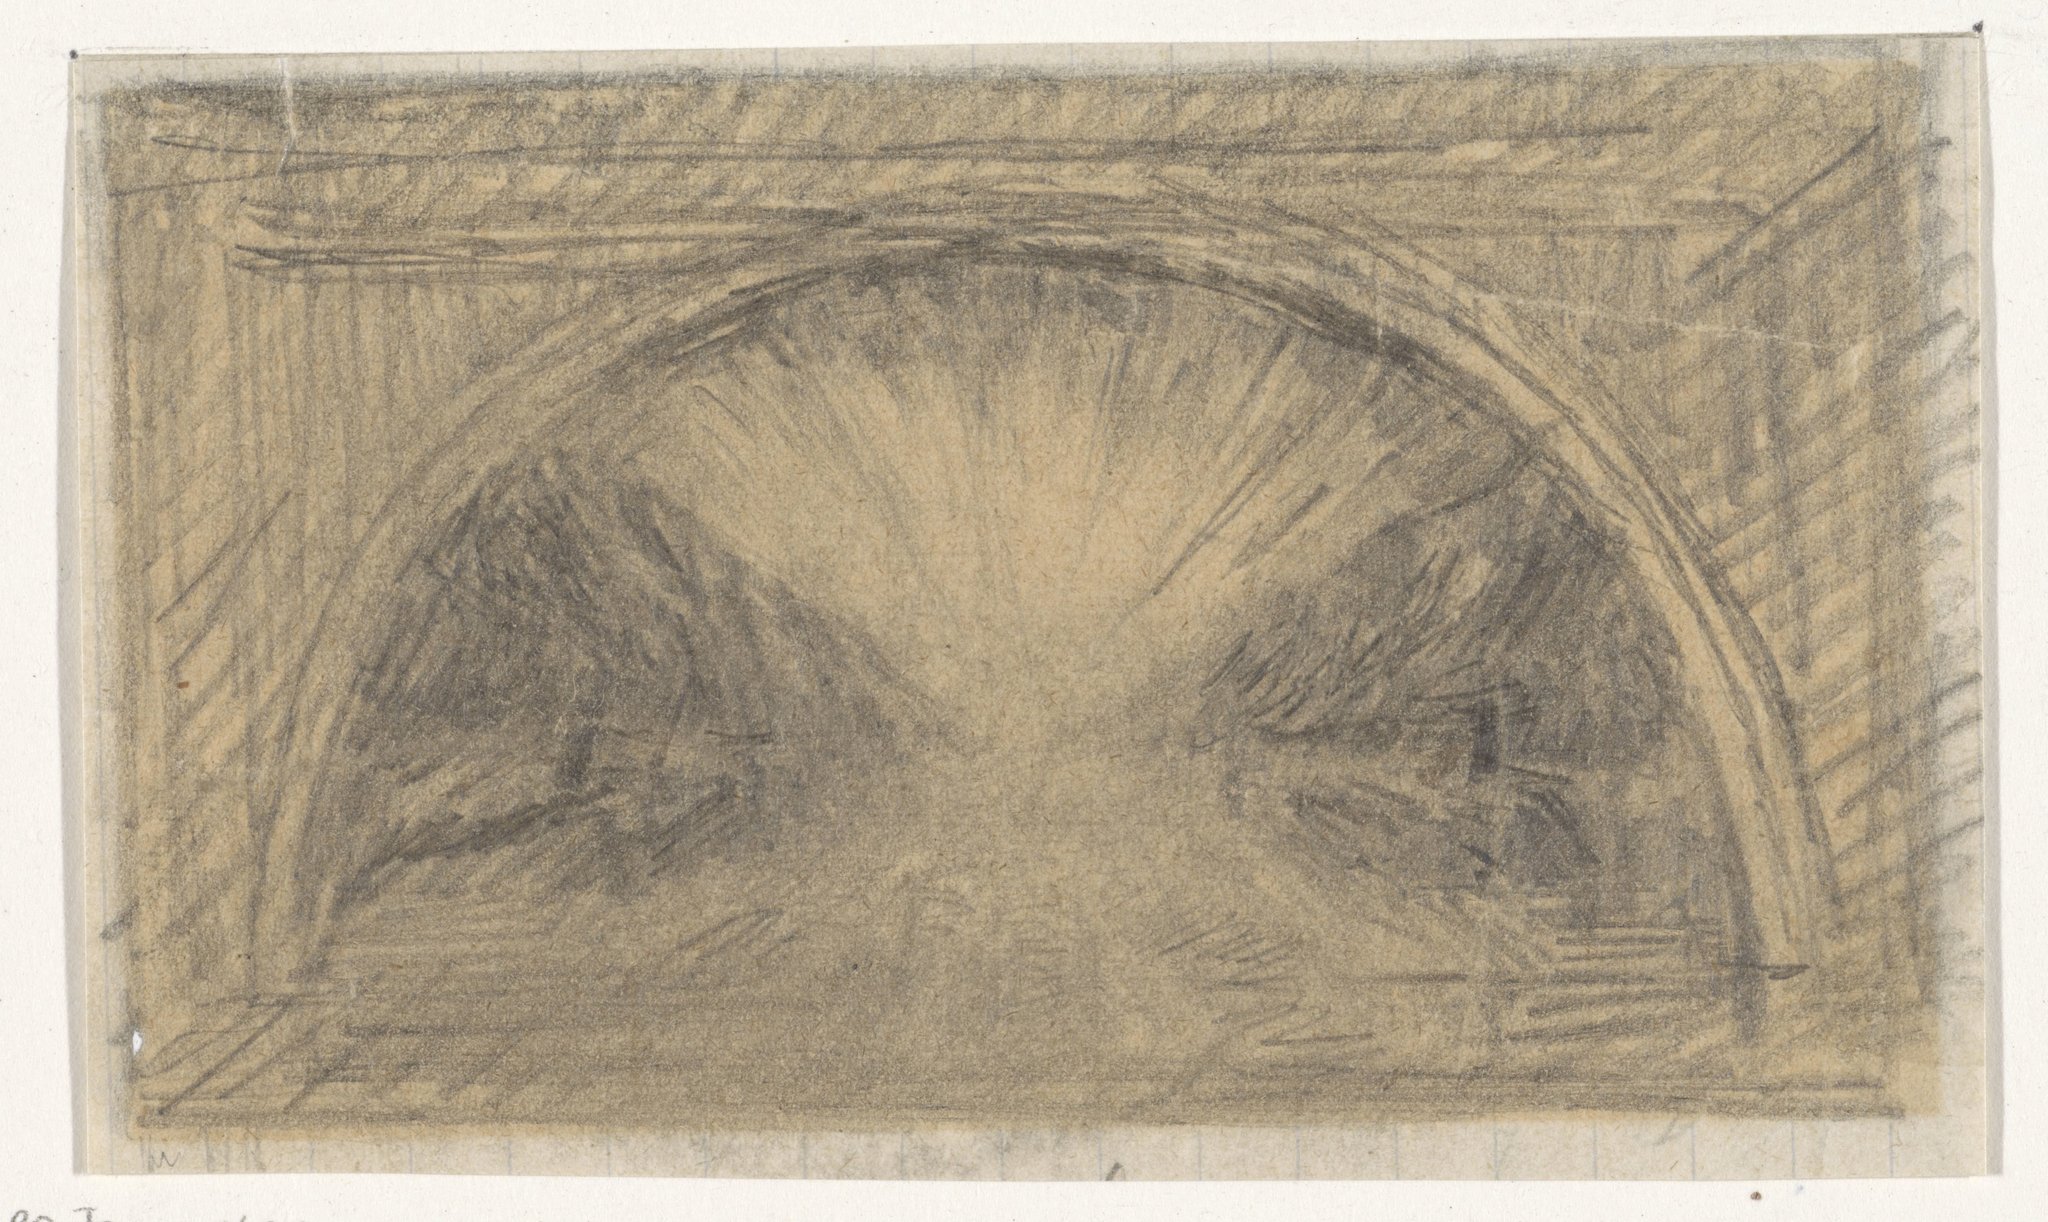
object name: drawing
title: Doorkijk door een boog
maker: thomas cool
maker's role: draughtsman, painter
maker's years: 1851-1904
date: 1861-1904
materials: paper, pencil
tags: landscape with ruins, rome